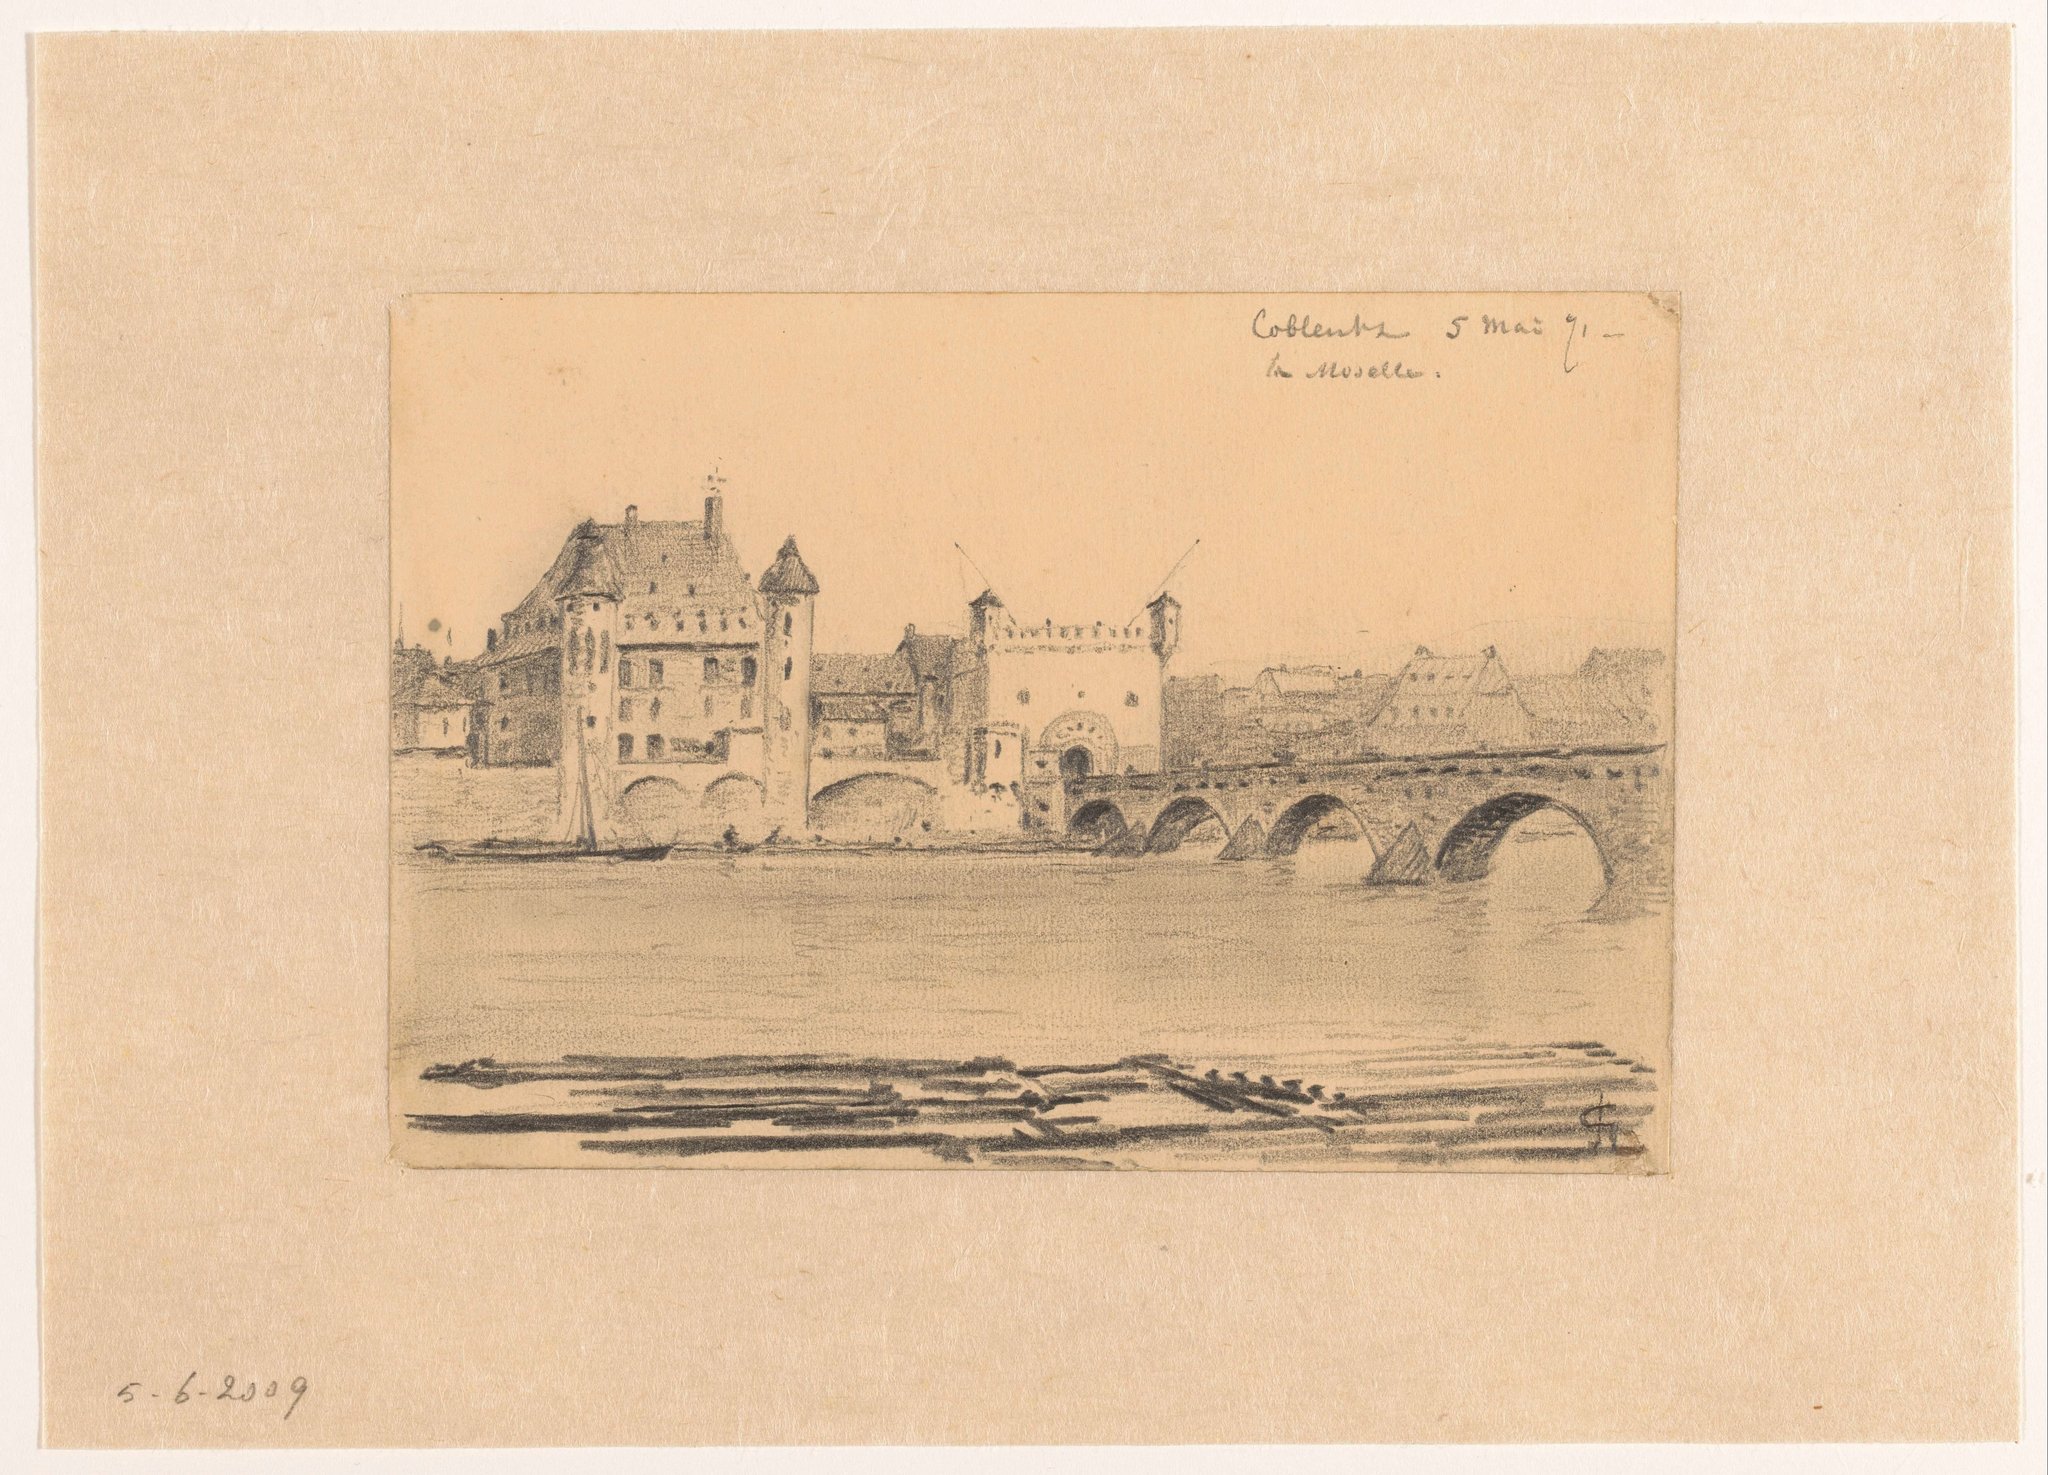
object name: drawing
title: Gezicht op Koblenz aan de Mozel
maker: carel nicolaas storm van s-gravesande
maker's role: draughtsman, print maker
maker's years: 1841-1924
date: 1871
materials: pencil, paper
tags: city-view in general; 'veduta'